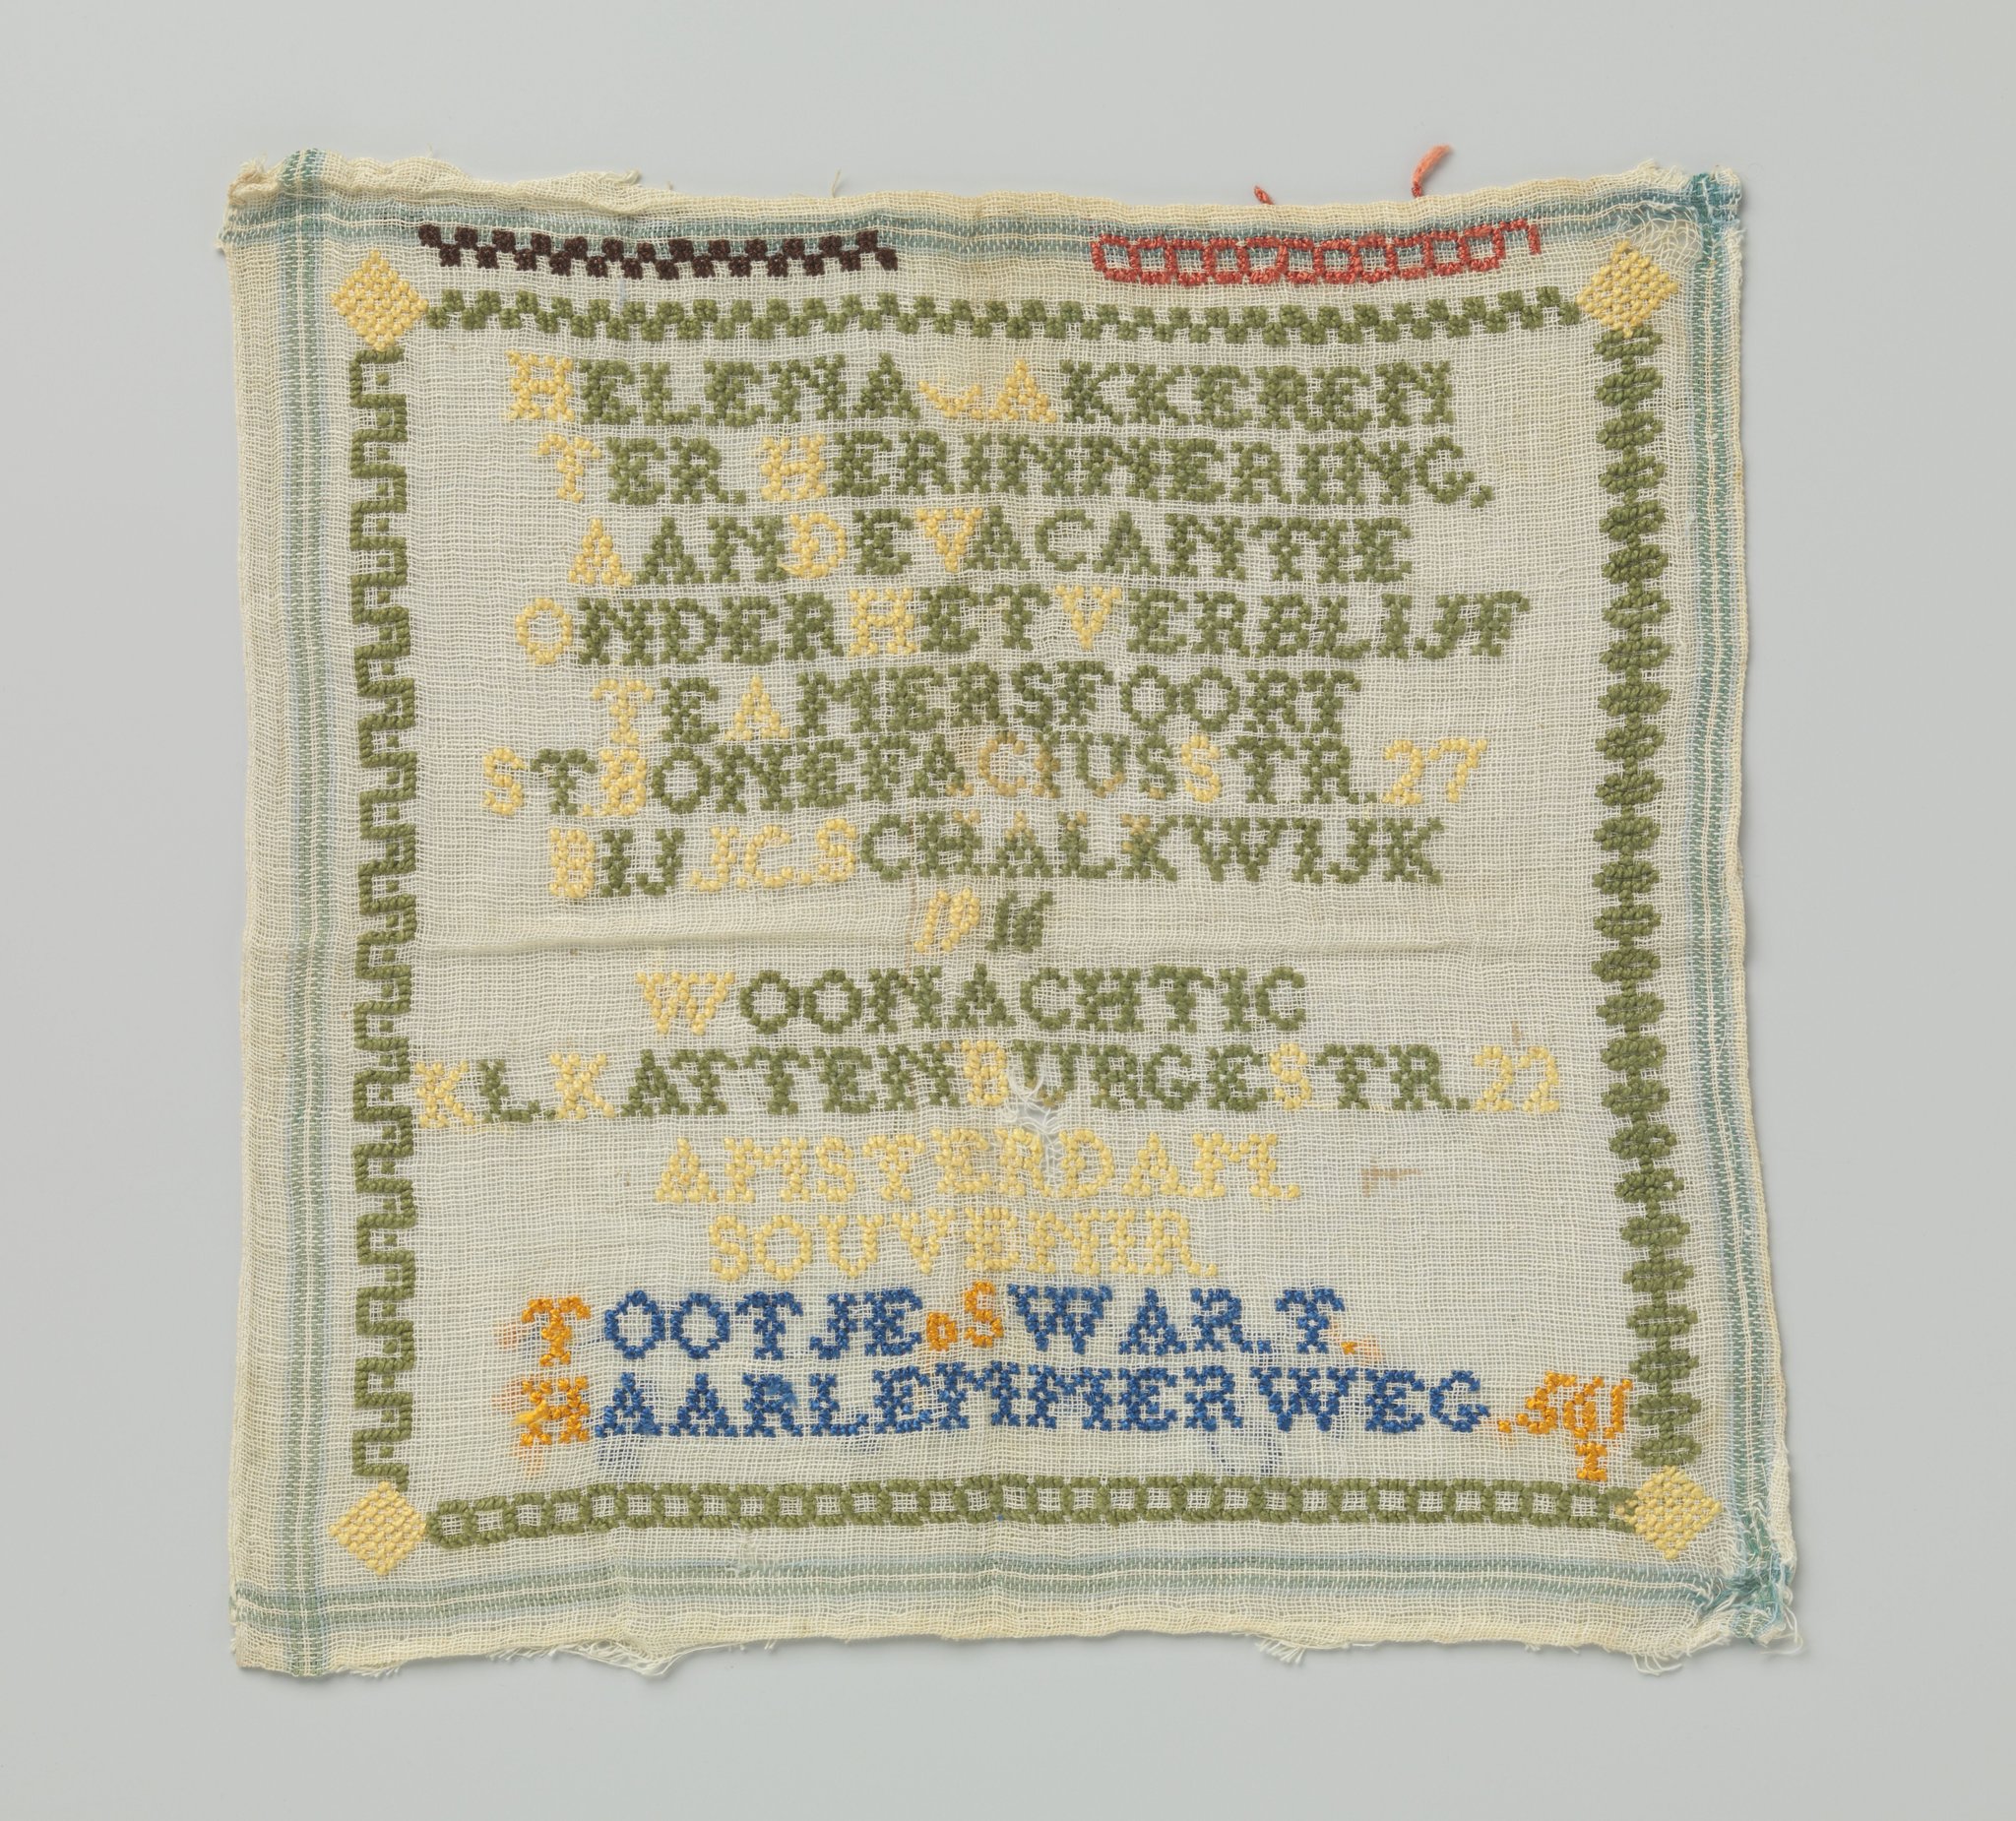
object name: merkdoek, merklap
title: Merklap van veelkleurige DMC op katoen.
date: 1916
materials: cotton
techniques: embroidered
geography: netherlands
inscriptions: date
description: Merklap van DMC garen op katoen. Het borduurwerk heeft de tekst: HELENA VAN AKKEREN TER HERINNERING AAN DE VACANTIE...BIJ J.C. SCHALKWIJK, de datering 1916 en de tekst: WOONACHTIG...HAARLEMMERWEG 561 I.